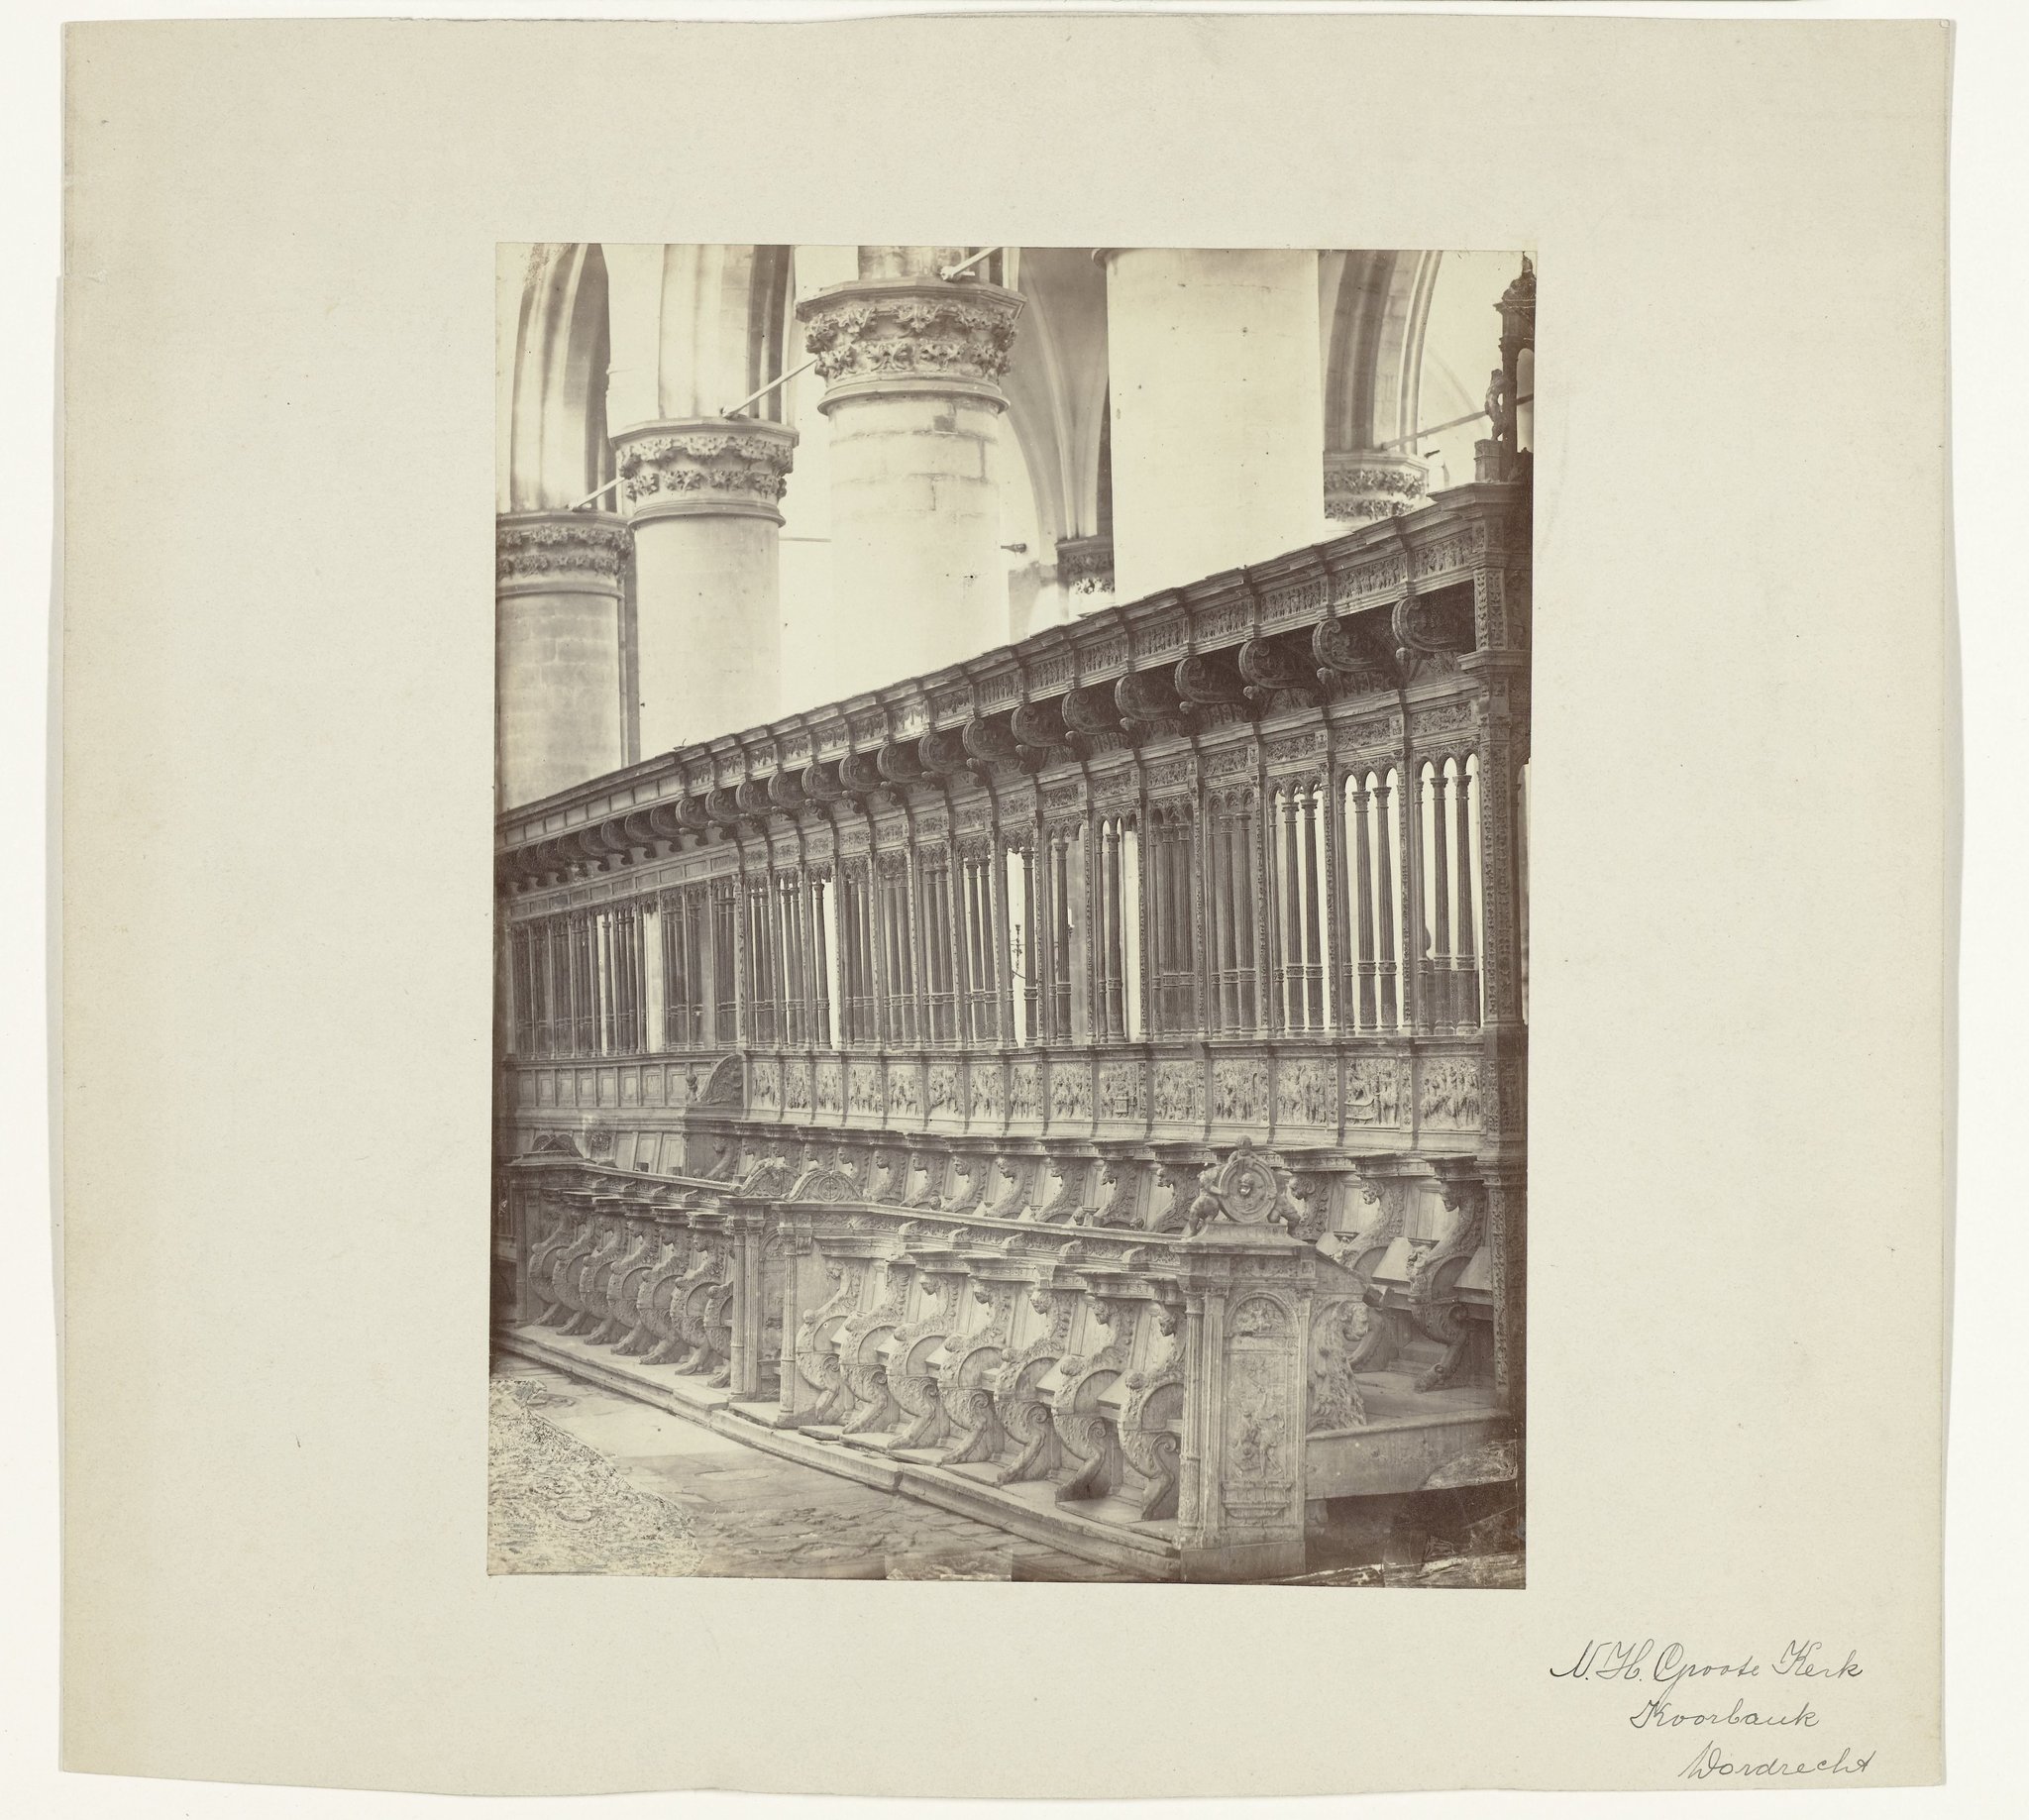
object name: photograph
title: N.H. Groote Kerk Koorbank Dordrecht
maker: Anonymous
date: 1890-1920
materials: cardboard, paper, photographic support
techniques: albumen print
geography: dordrecht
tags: parts of church interior: choir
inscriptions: caption: ‘N.H. Groote Kerk / Koorbank / Dordrecht’